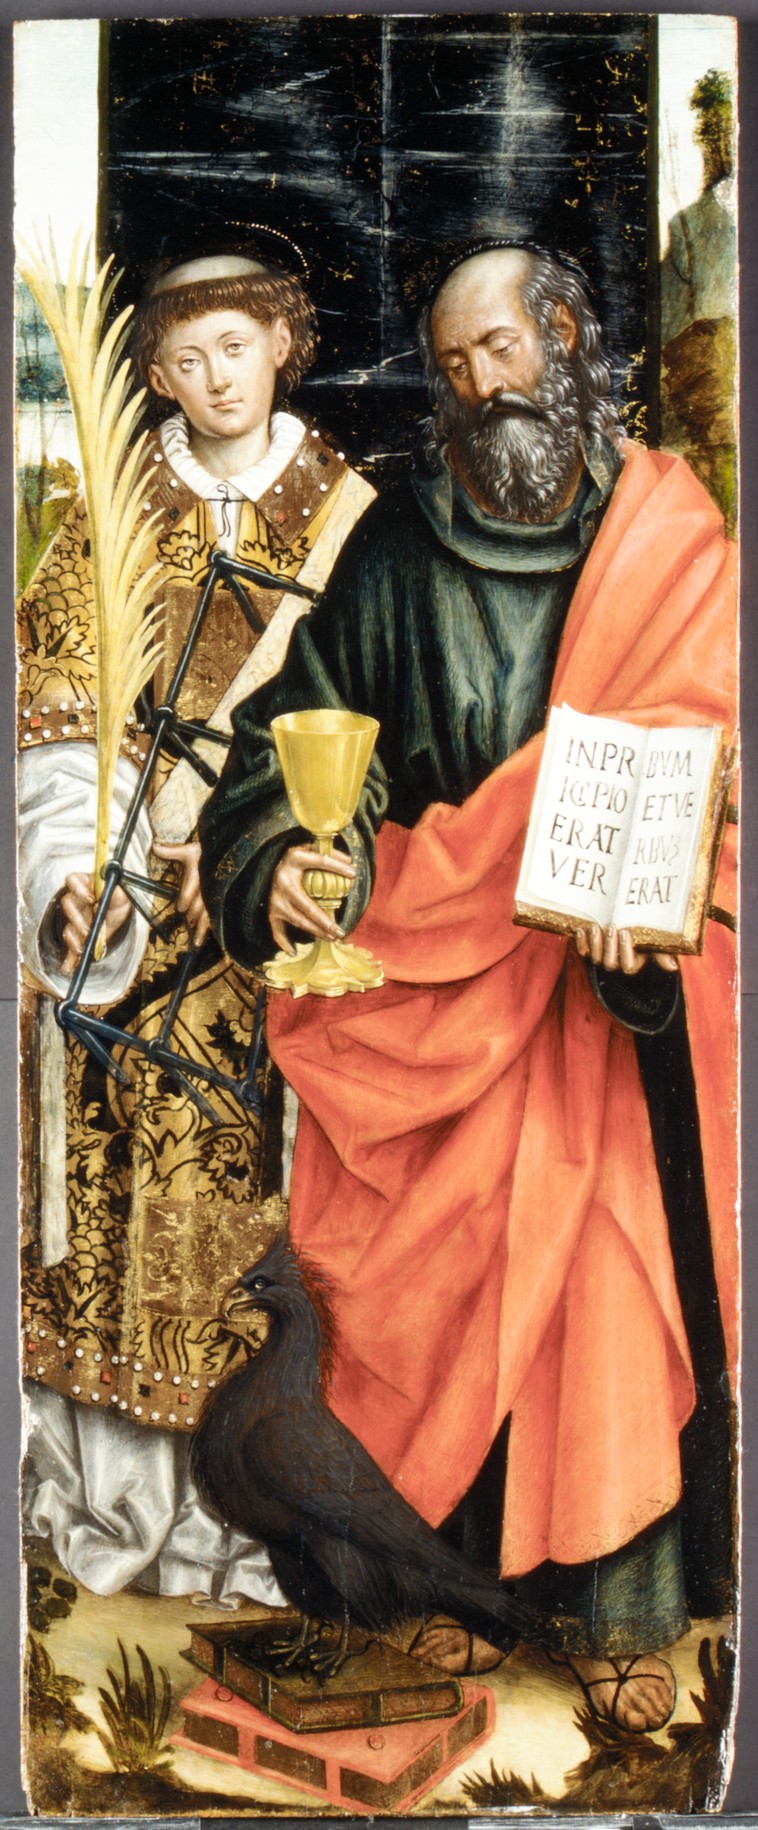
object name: painting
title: Saints John the Evangelist and Lawrence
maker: defendente ferrari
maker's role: artist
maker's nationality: italian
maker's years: 1510-1531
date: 1510-1531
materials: oil, wood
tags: books,saint john the evangelist,saint lawrence,chalices